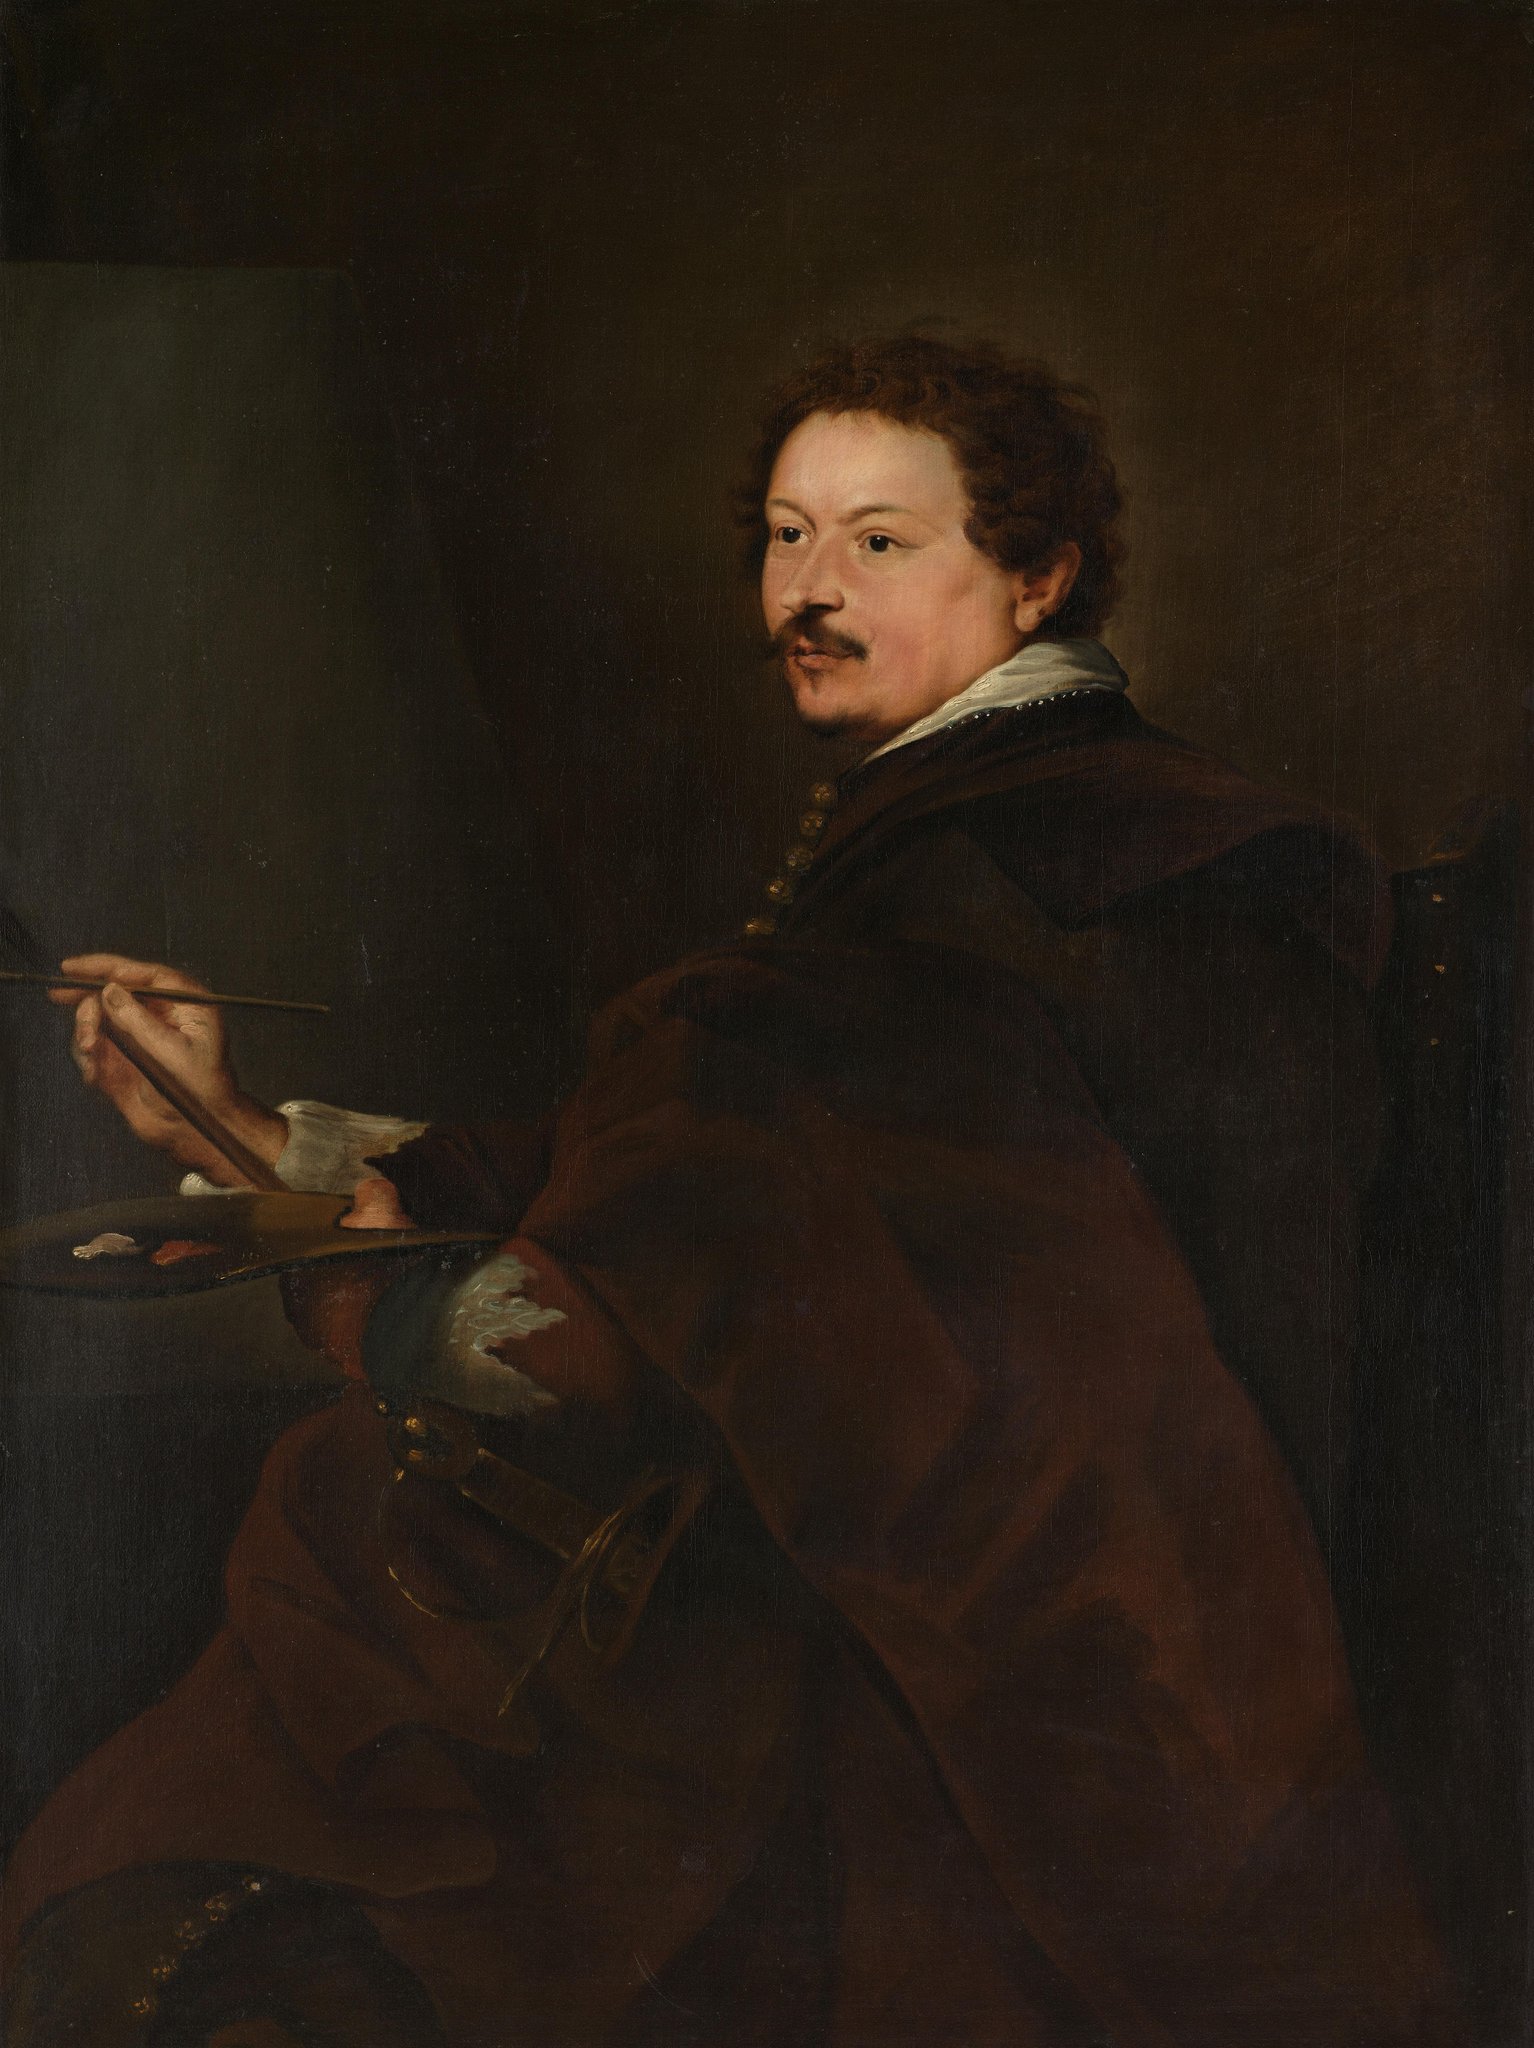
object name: painting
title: Portrait of Andries van Eertvelt (1590-1652)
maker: Anonymous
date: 1650-1700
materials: canvas, oil, paint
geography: southern netherlands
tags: antwerp, painter, draughtsman, andries van eertvelt, historical persons, portrait, self-portrait of artist, picture, painting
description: Portret van de schilder Andries van Eertvelt, zittend werkend aan een schilderij. Penseel in de rechterhand, palet in de linker. Kopie naar het origineel in Augsburg.